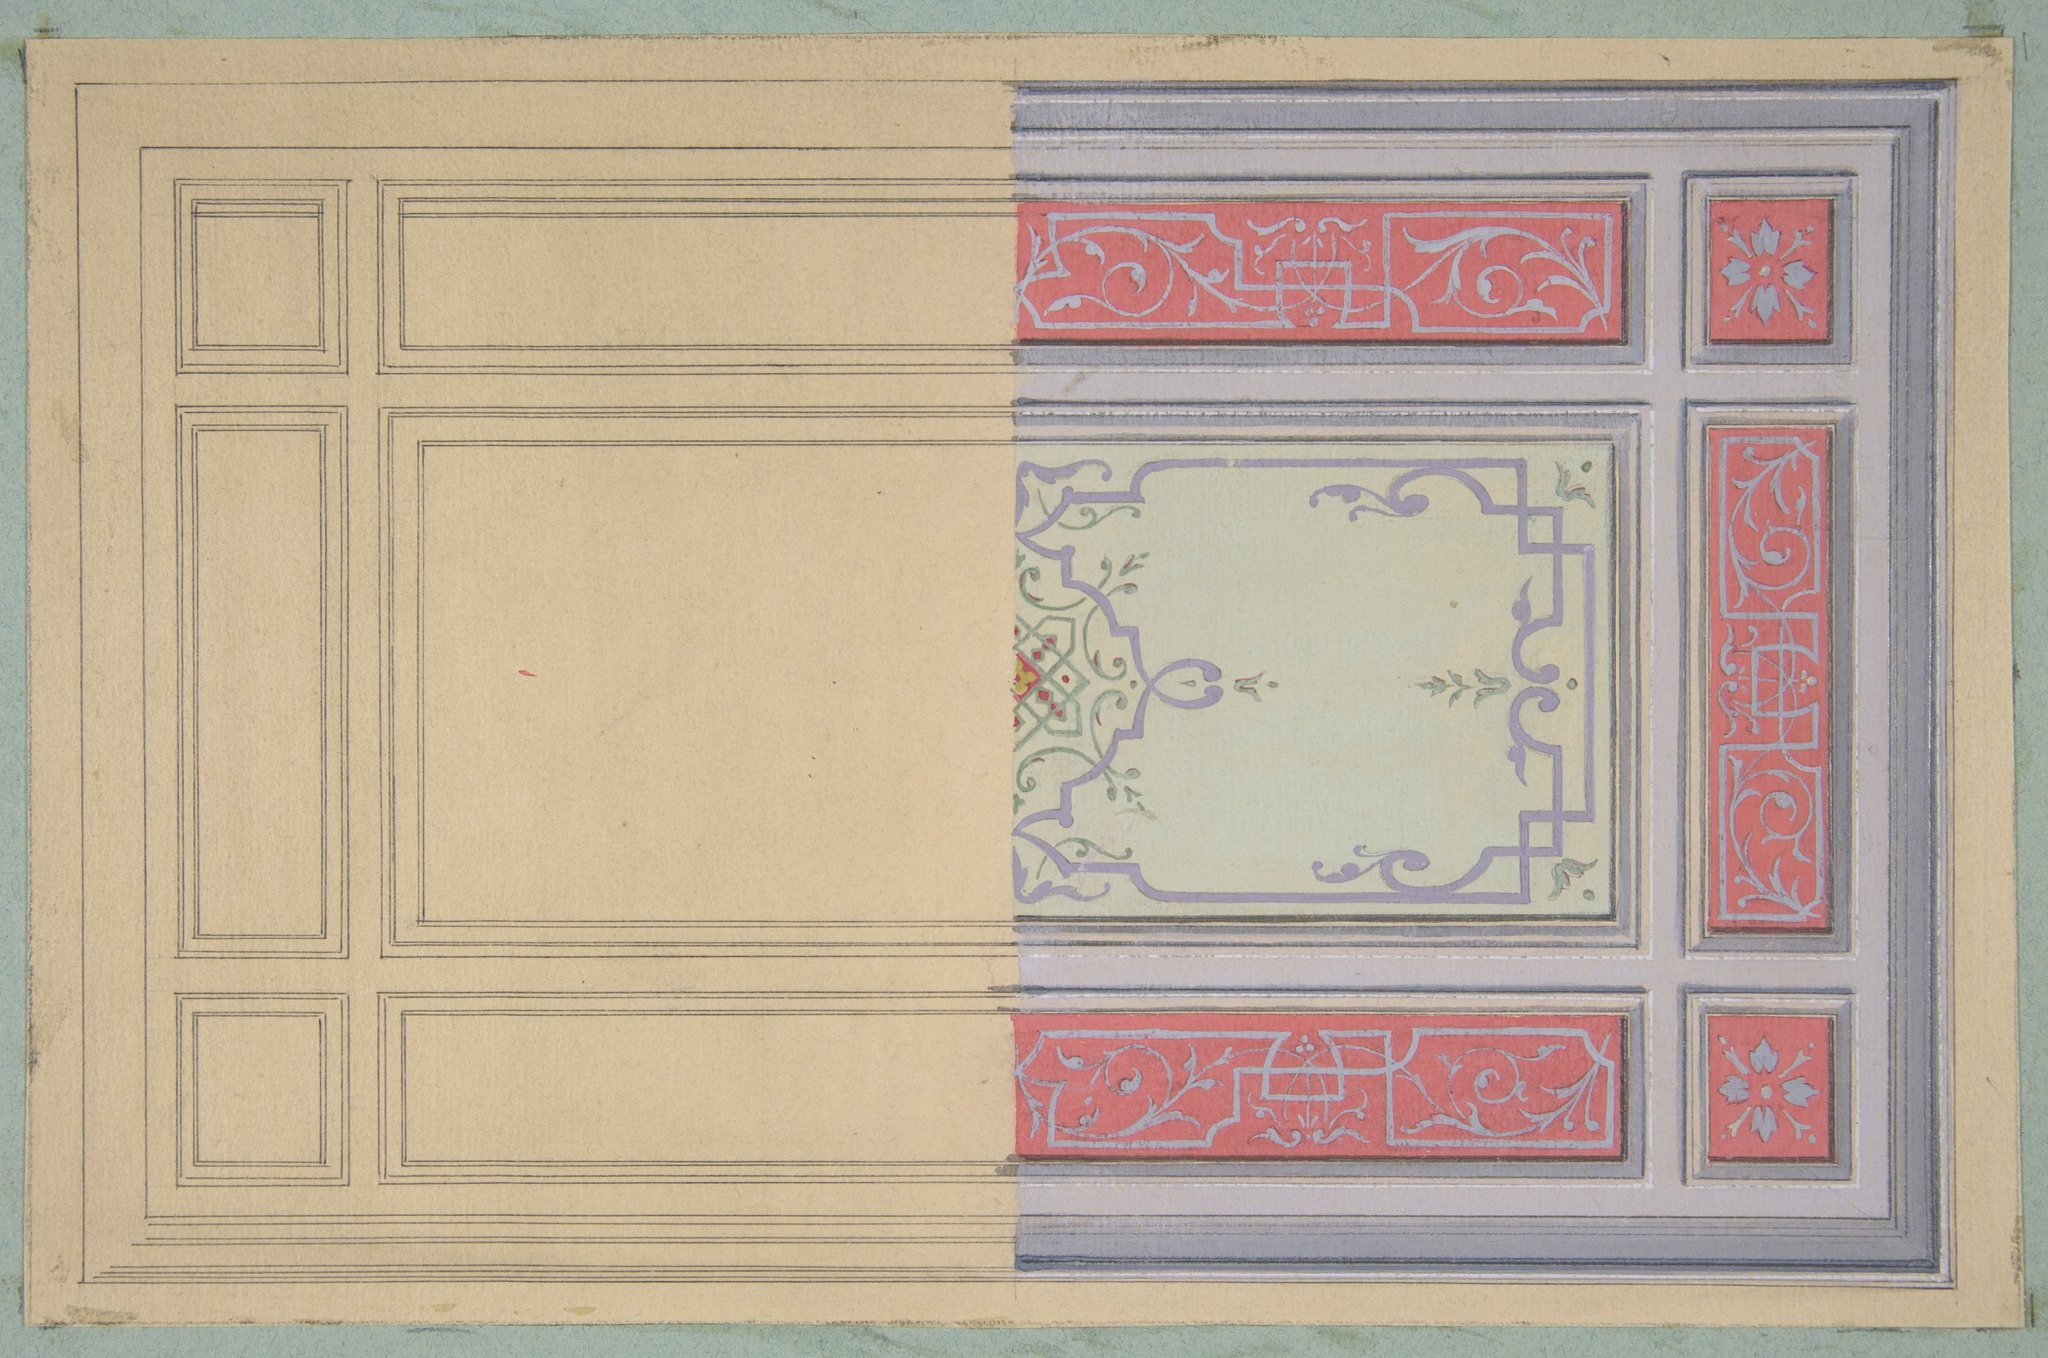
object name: drawing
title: Design for the painted decoration of a ceiling in strapwork and rinceaux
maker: jules-edmond-charles lachaise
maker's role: artist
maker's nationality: french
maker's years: 1897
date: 1851-1900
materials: gouache, graphite, watercolor, paper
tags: ceilings